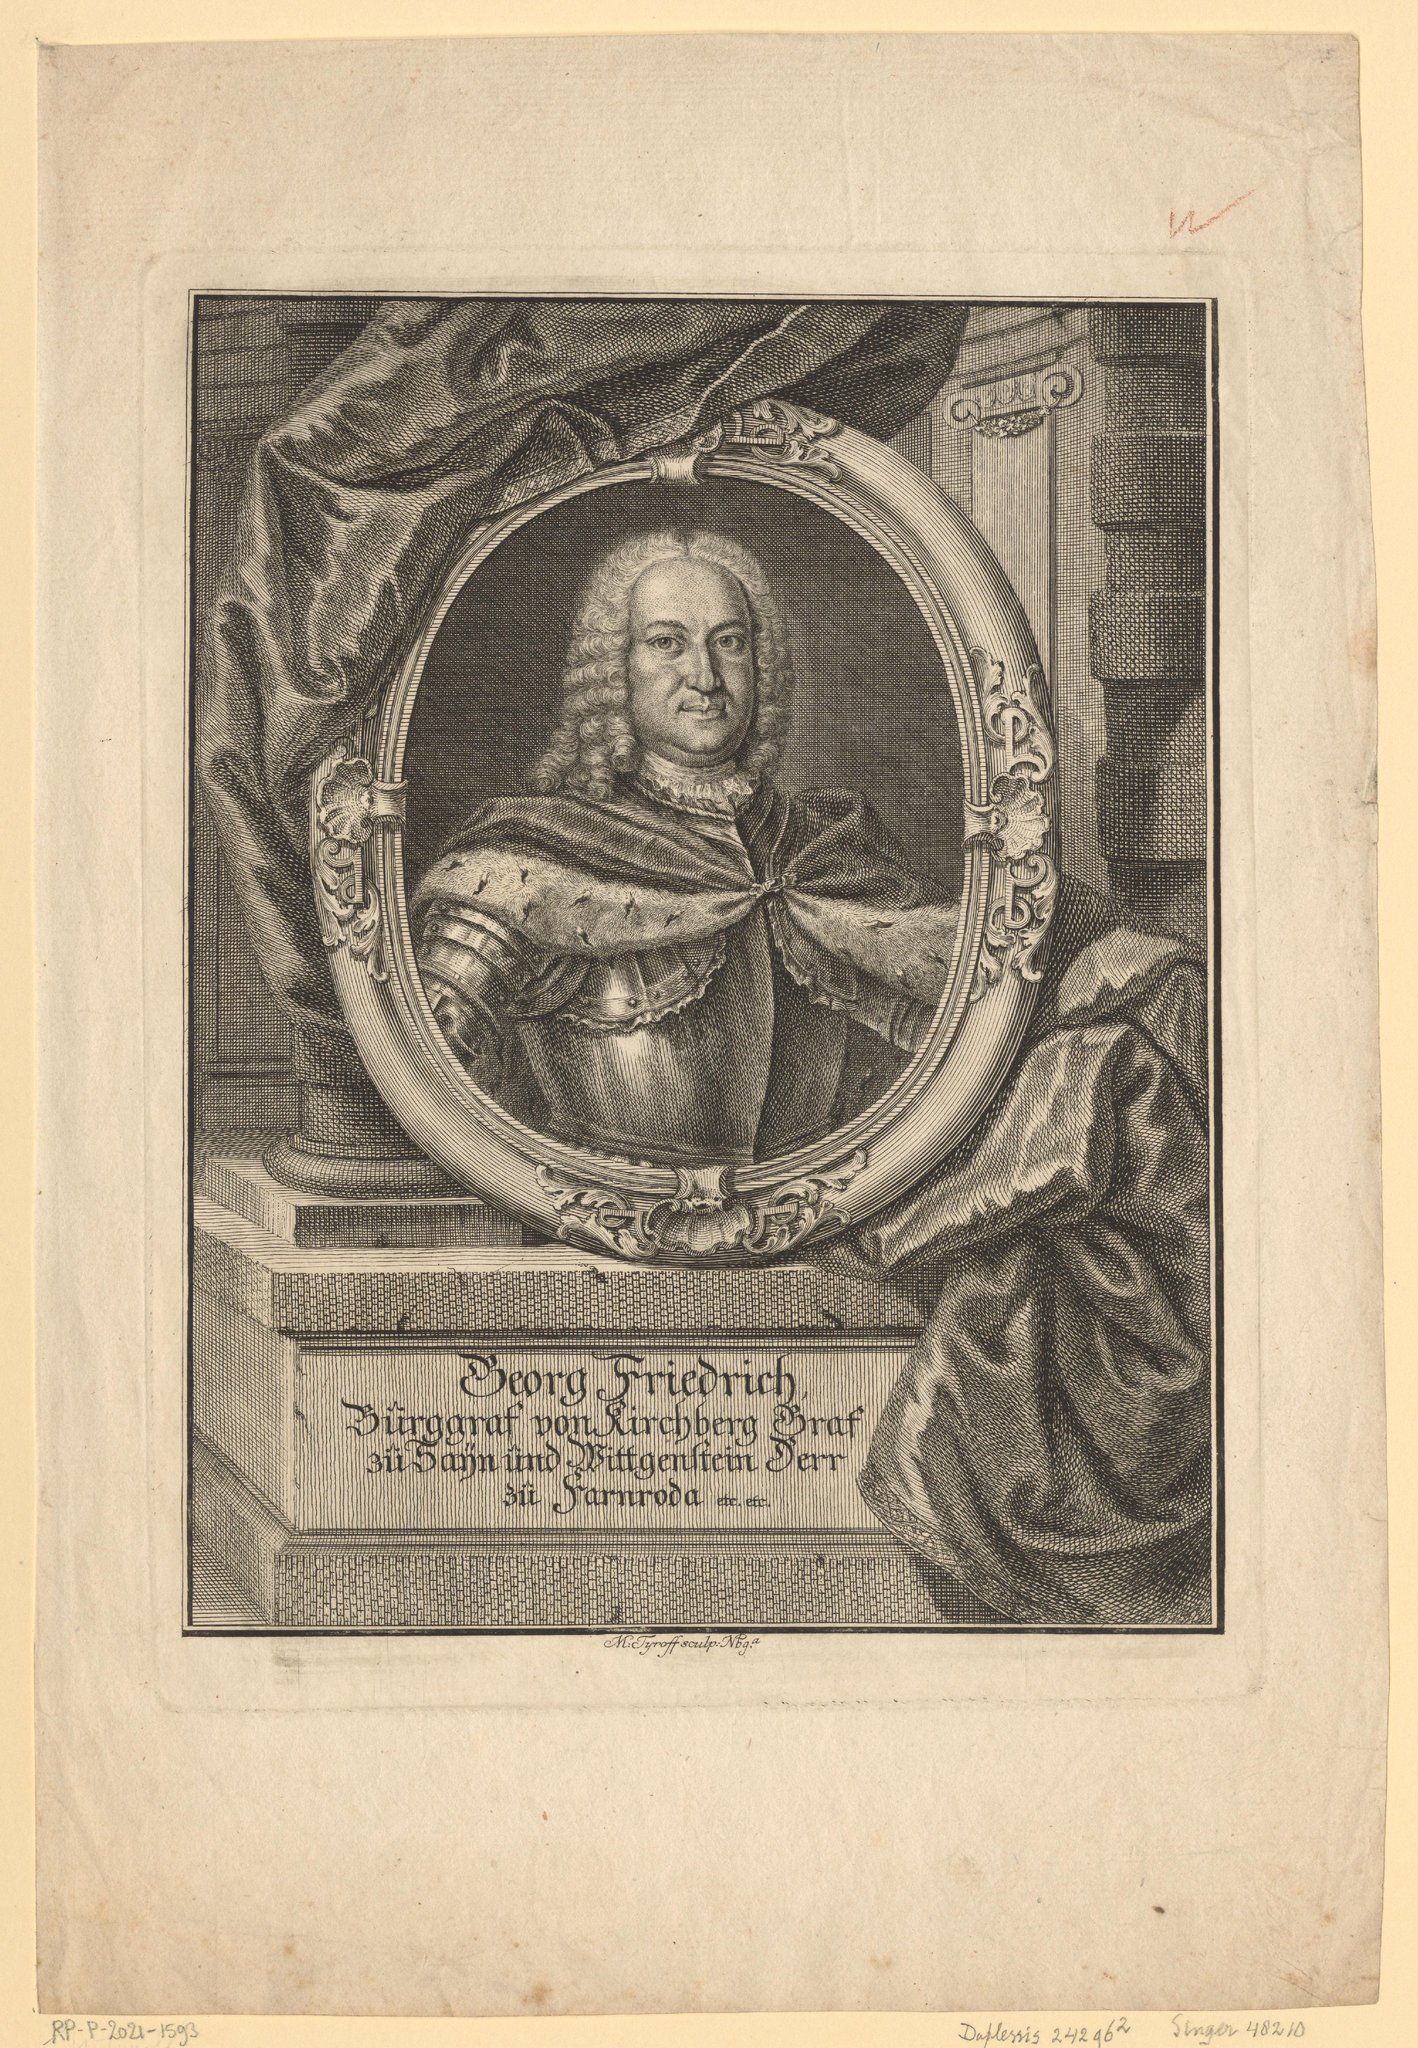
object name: print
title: Portret van Georg Friedrich von Kirchberg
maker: martin tyroff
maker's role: print maker, publisher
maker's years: 1704-1779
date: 1714-1779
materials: paper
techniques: engraving, etching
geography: nuremberg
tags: armour, historical persons